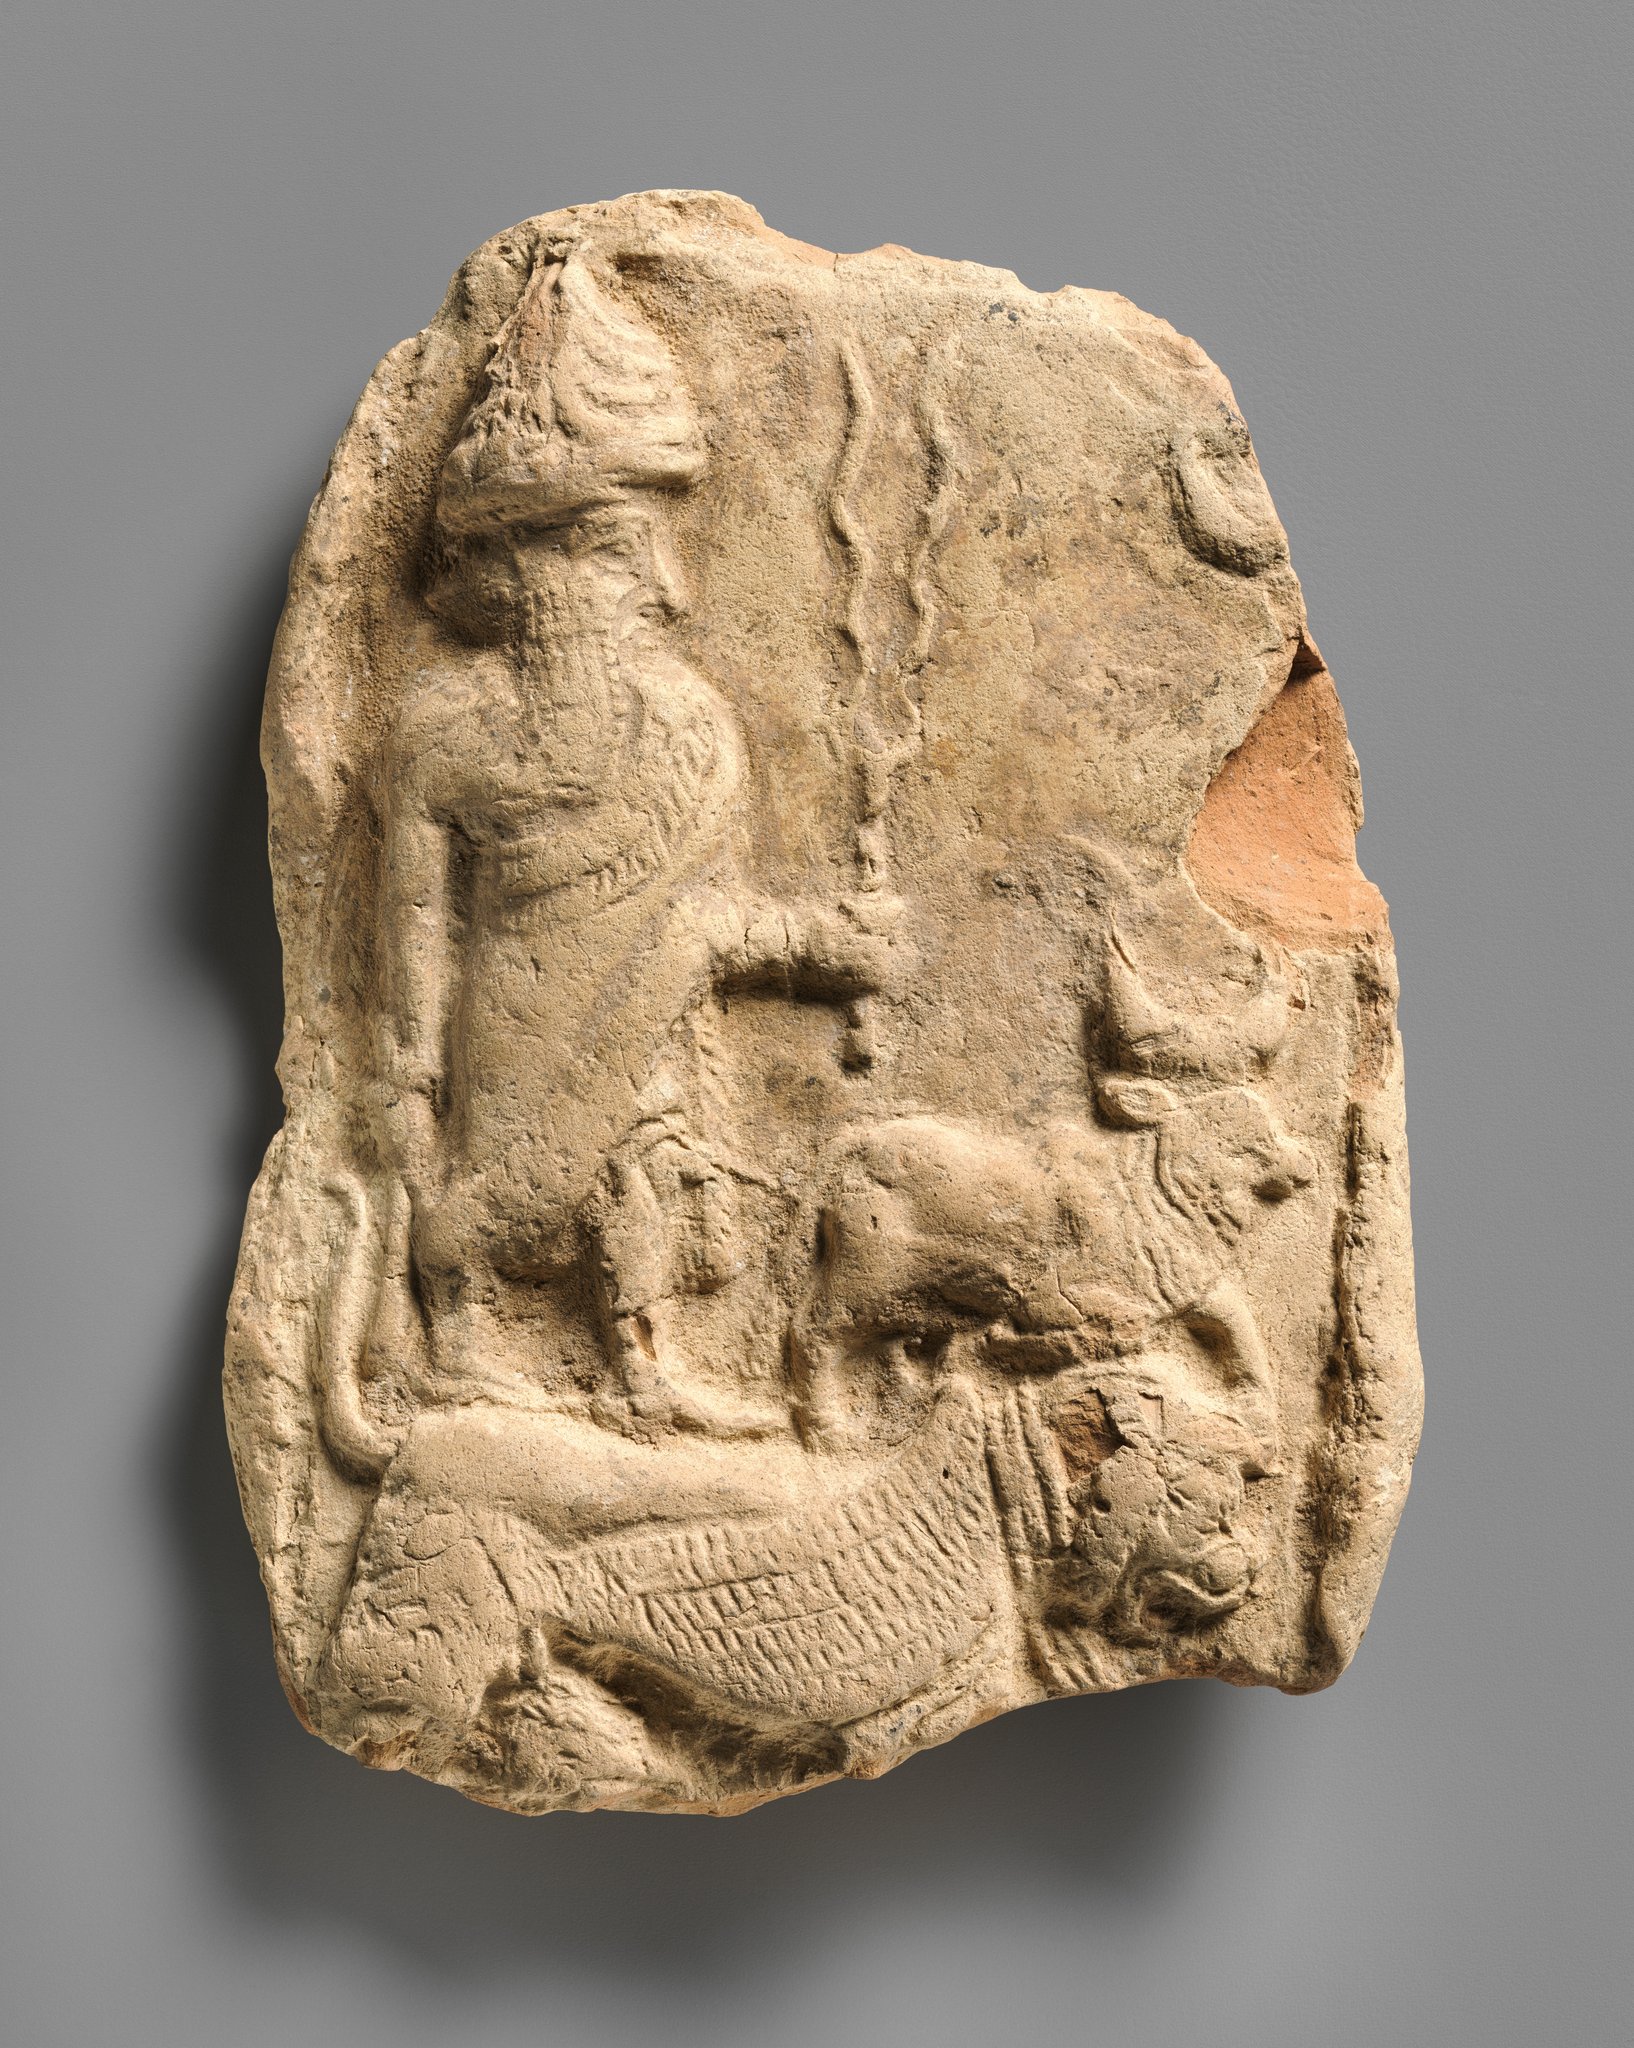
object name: relief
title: Molded plaque: the weather god Adad and a bull standing on a lion-dragon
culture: babylonian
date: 2000-1600 BCE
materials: ceramic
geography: southern mesopotamia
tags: dragons,bulls,lions